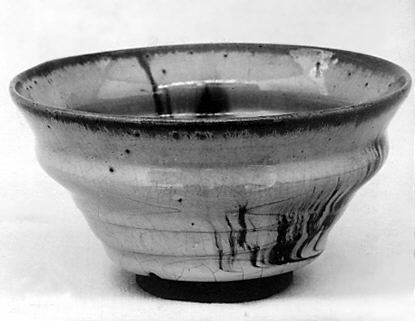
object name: teabowl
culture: japanese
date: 1801-1900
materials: clay, glaze